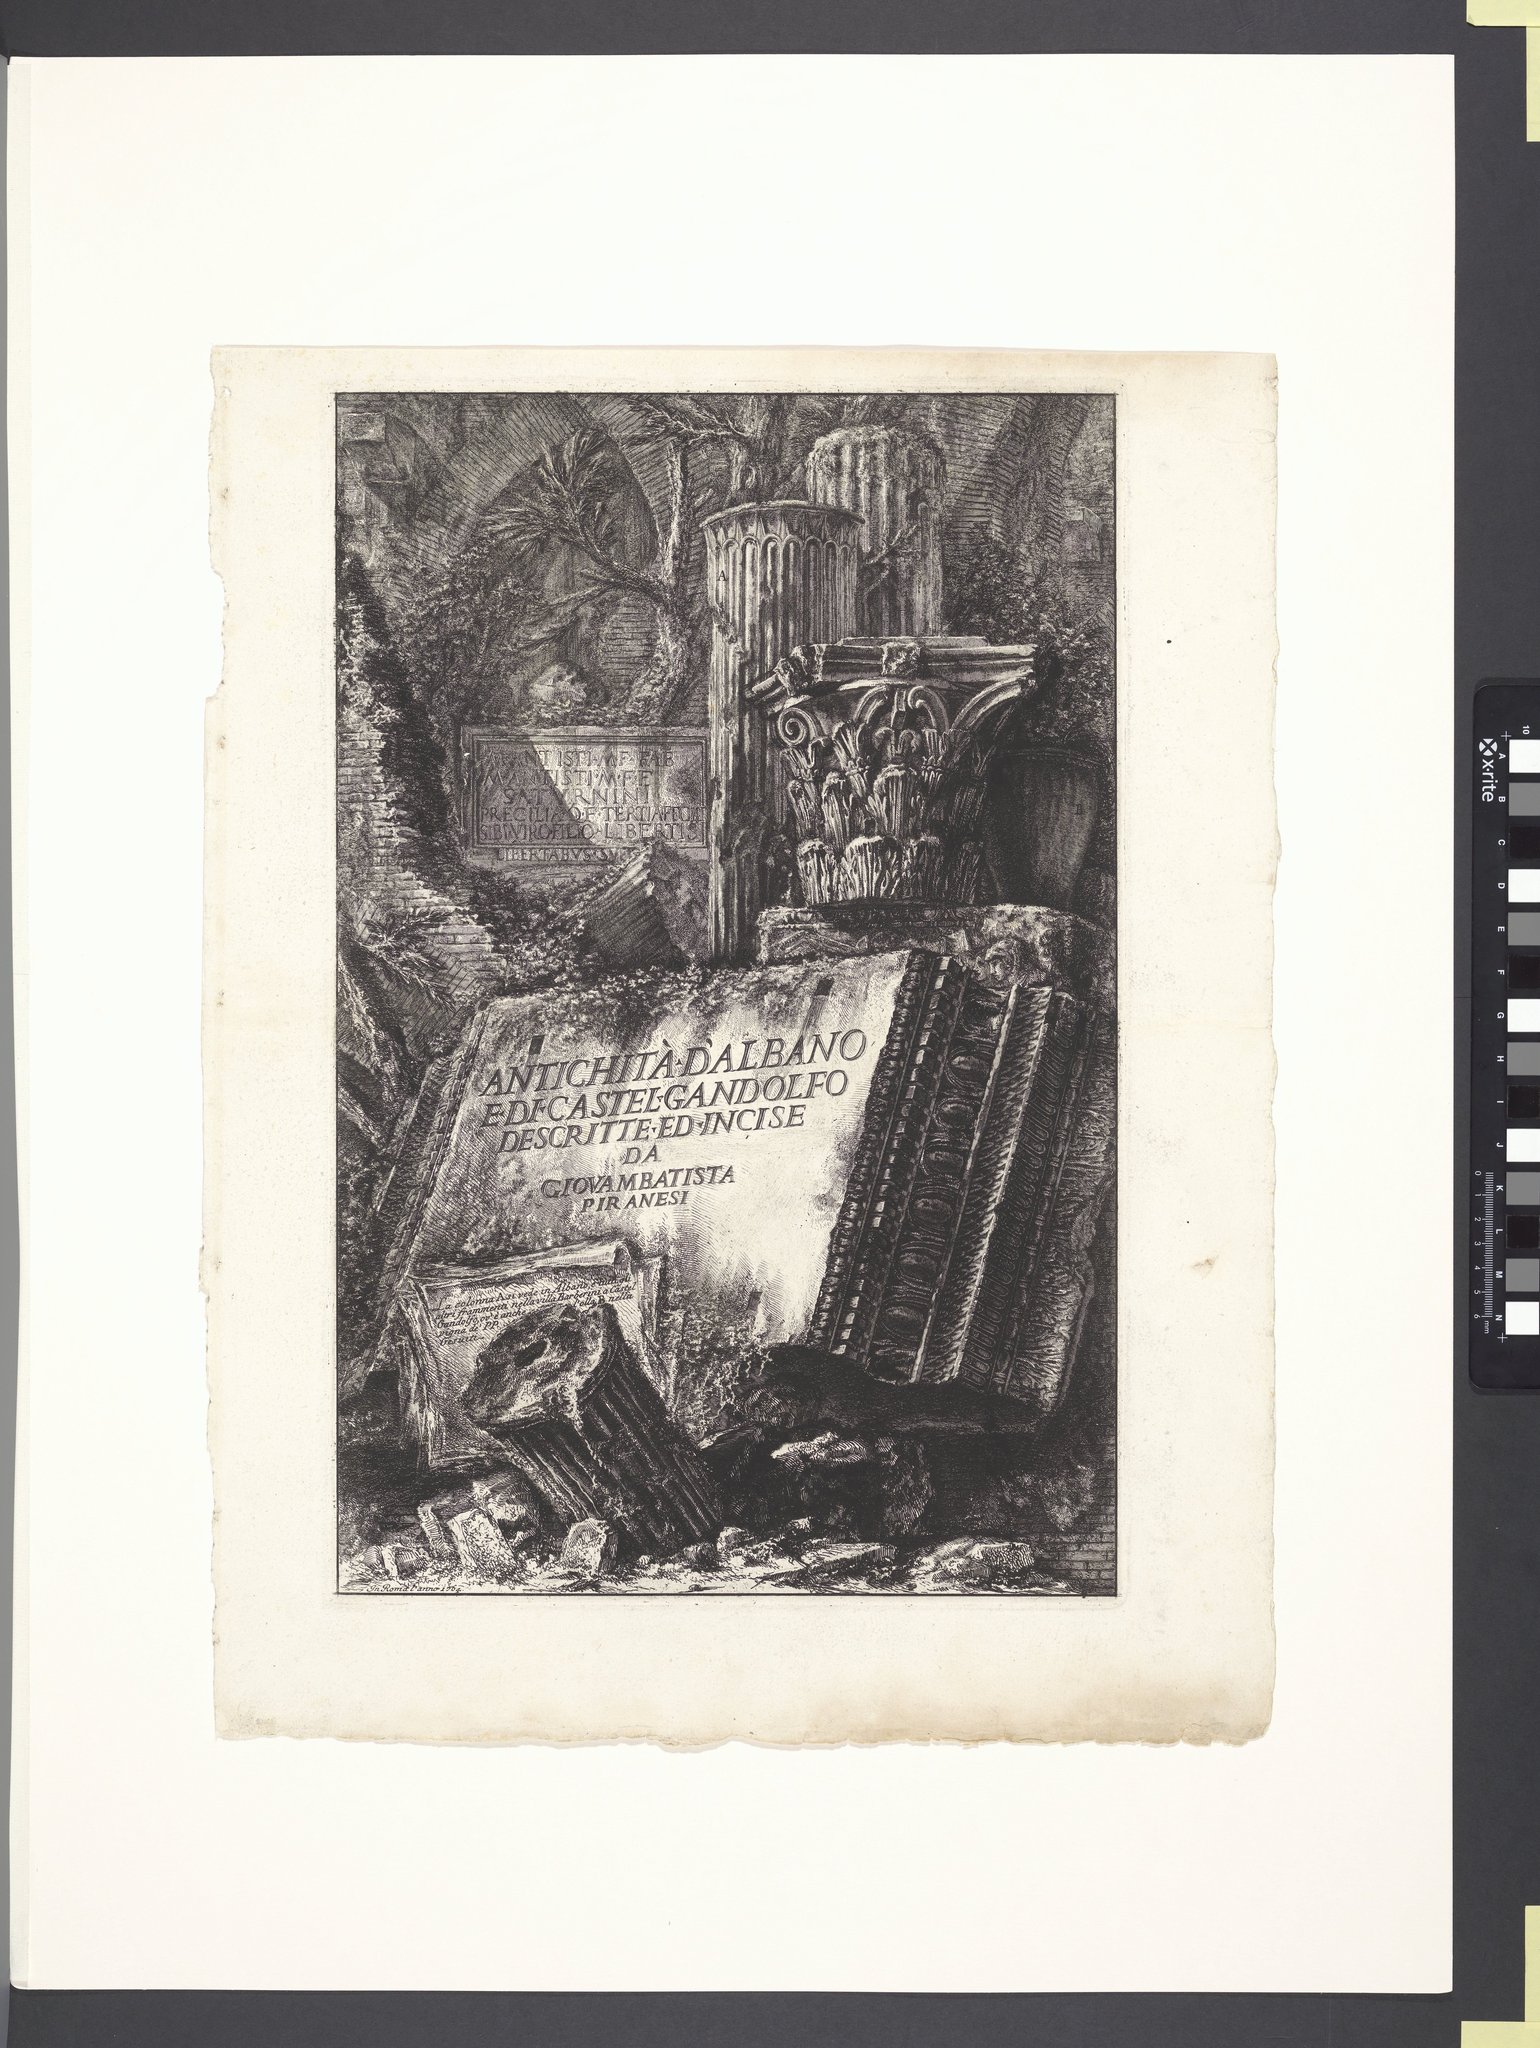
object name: print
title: Antichità d'Albano e di Castel Gandolfo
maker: giovanni battista piranesi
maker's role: designer, draughtsman, print maker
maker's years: 1720-1778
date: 1764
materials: paper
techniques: etching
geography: rome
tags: column, pillar ~ architecture, ruin of a building ~ architecture, temple, shrine ~ roman religion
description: Deze prent maakt deel uit van de serie van 33 prenten (inclusief titelprent, opdracht, vignet en ornamentele letter) met de titel 'Antichità d'Albano e di Castel Gandolfo'.